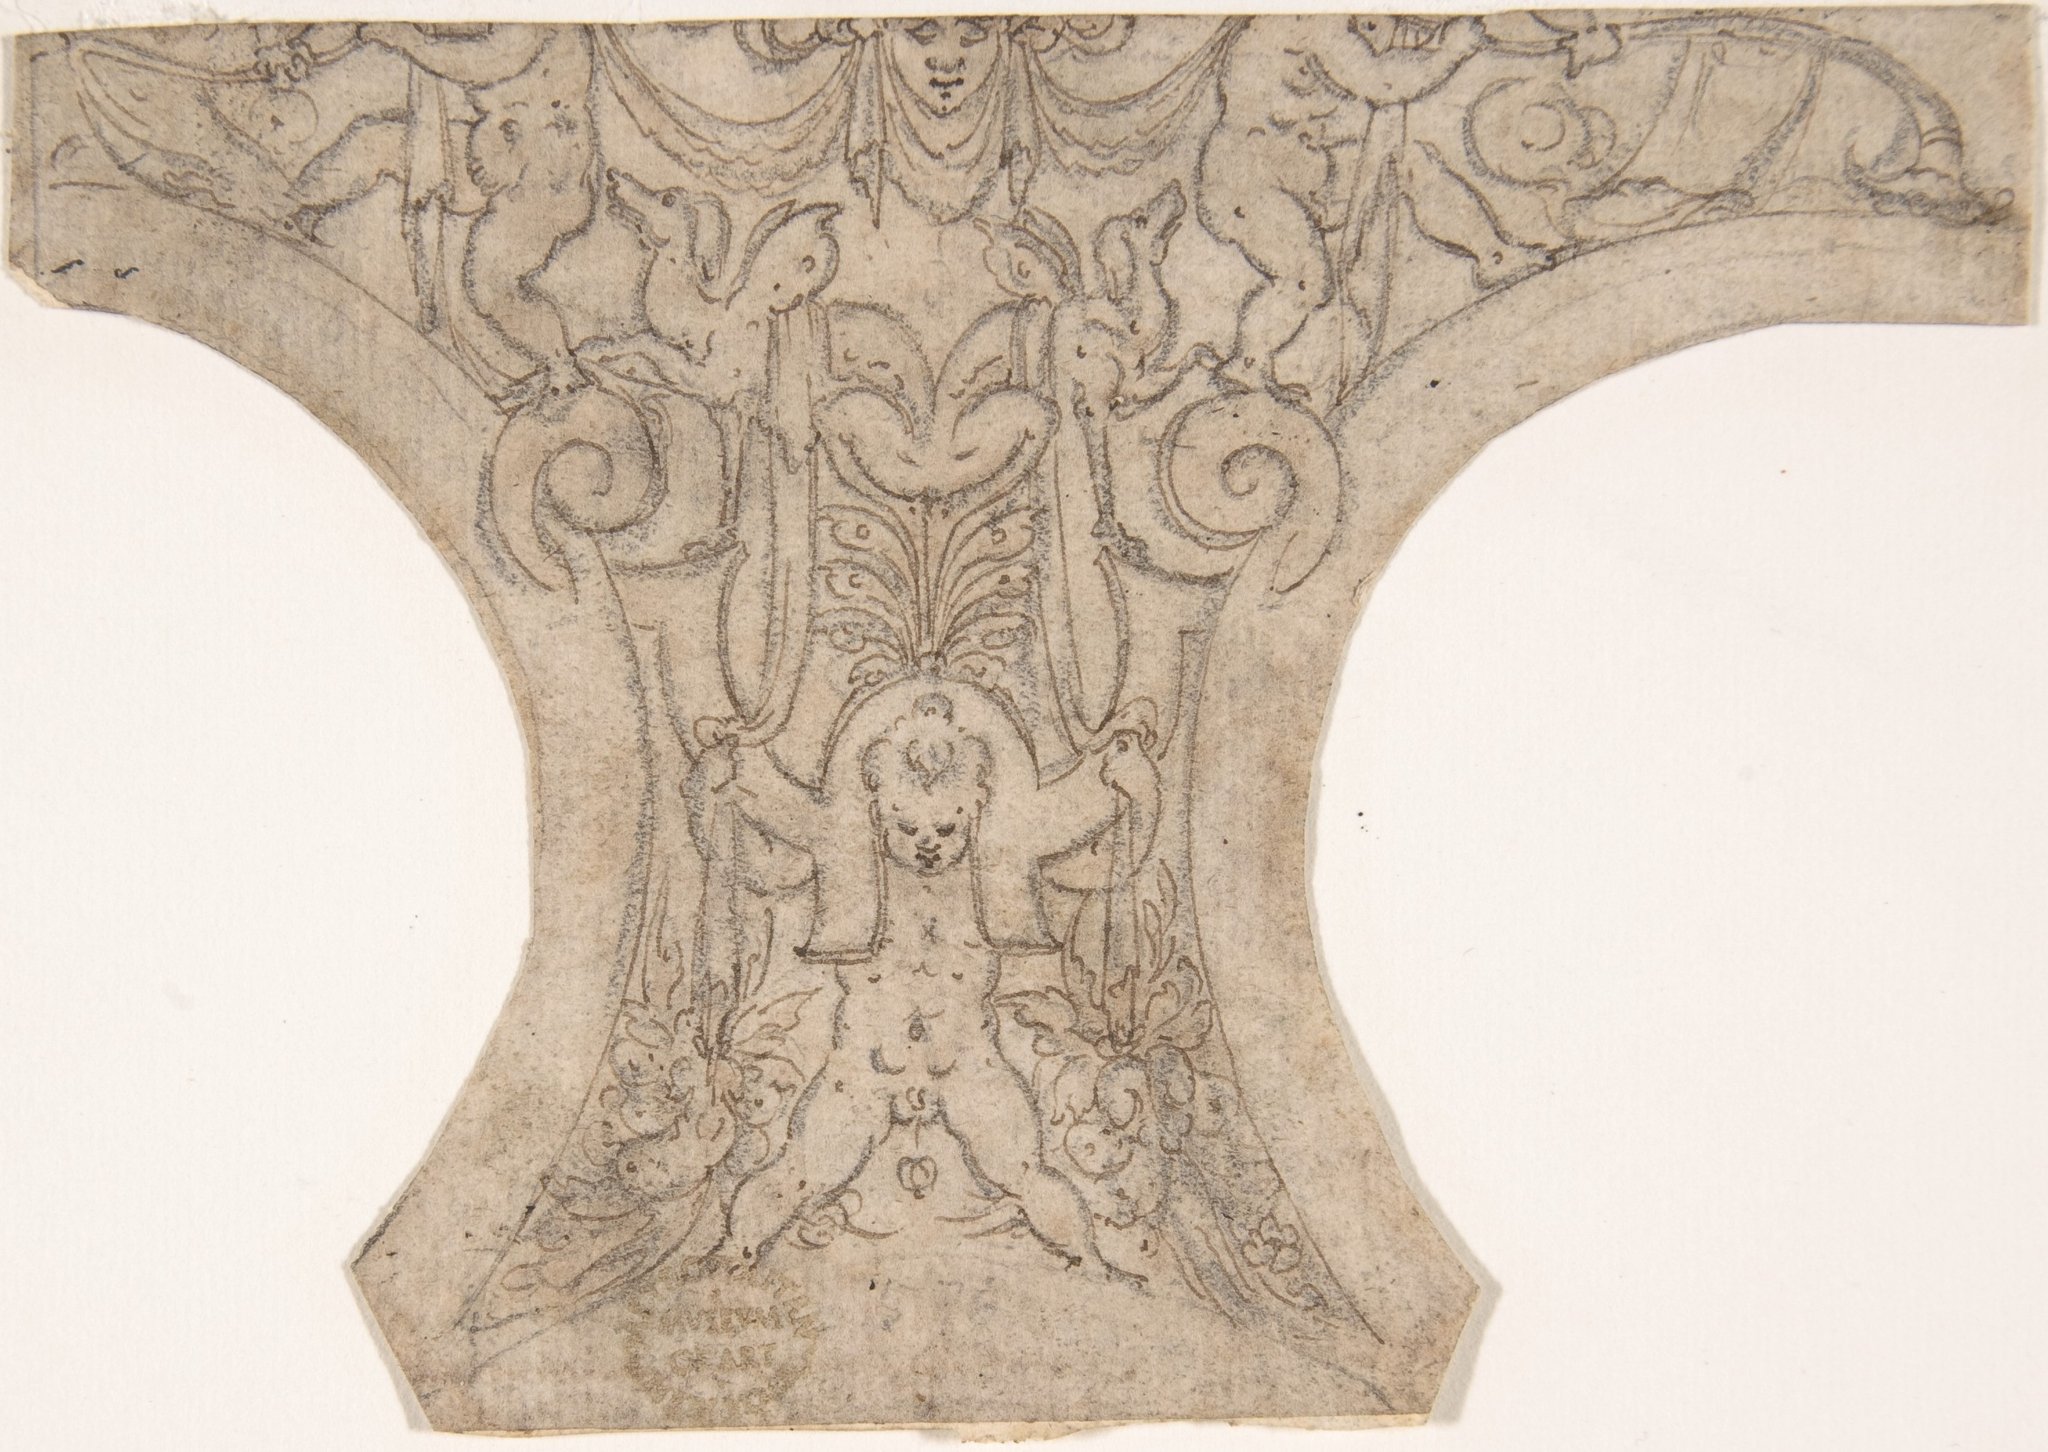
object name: drawing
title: Decoration for a Spandrel in a Cove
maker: anonymous, italian, 16th century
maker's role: artist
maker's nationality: italian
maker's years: 1550-1600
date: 1501-1600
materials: chalk, ink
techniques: pen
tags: ornament